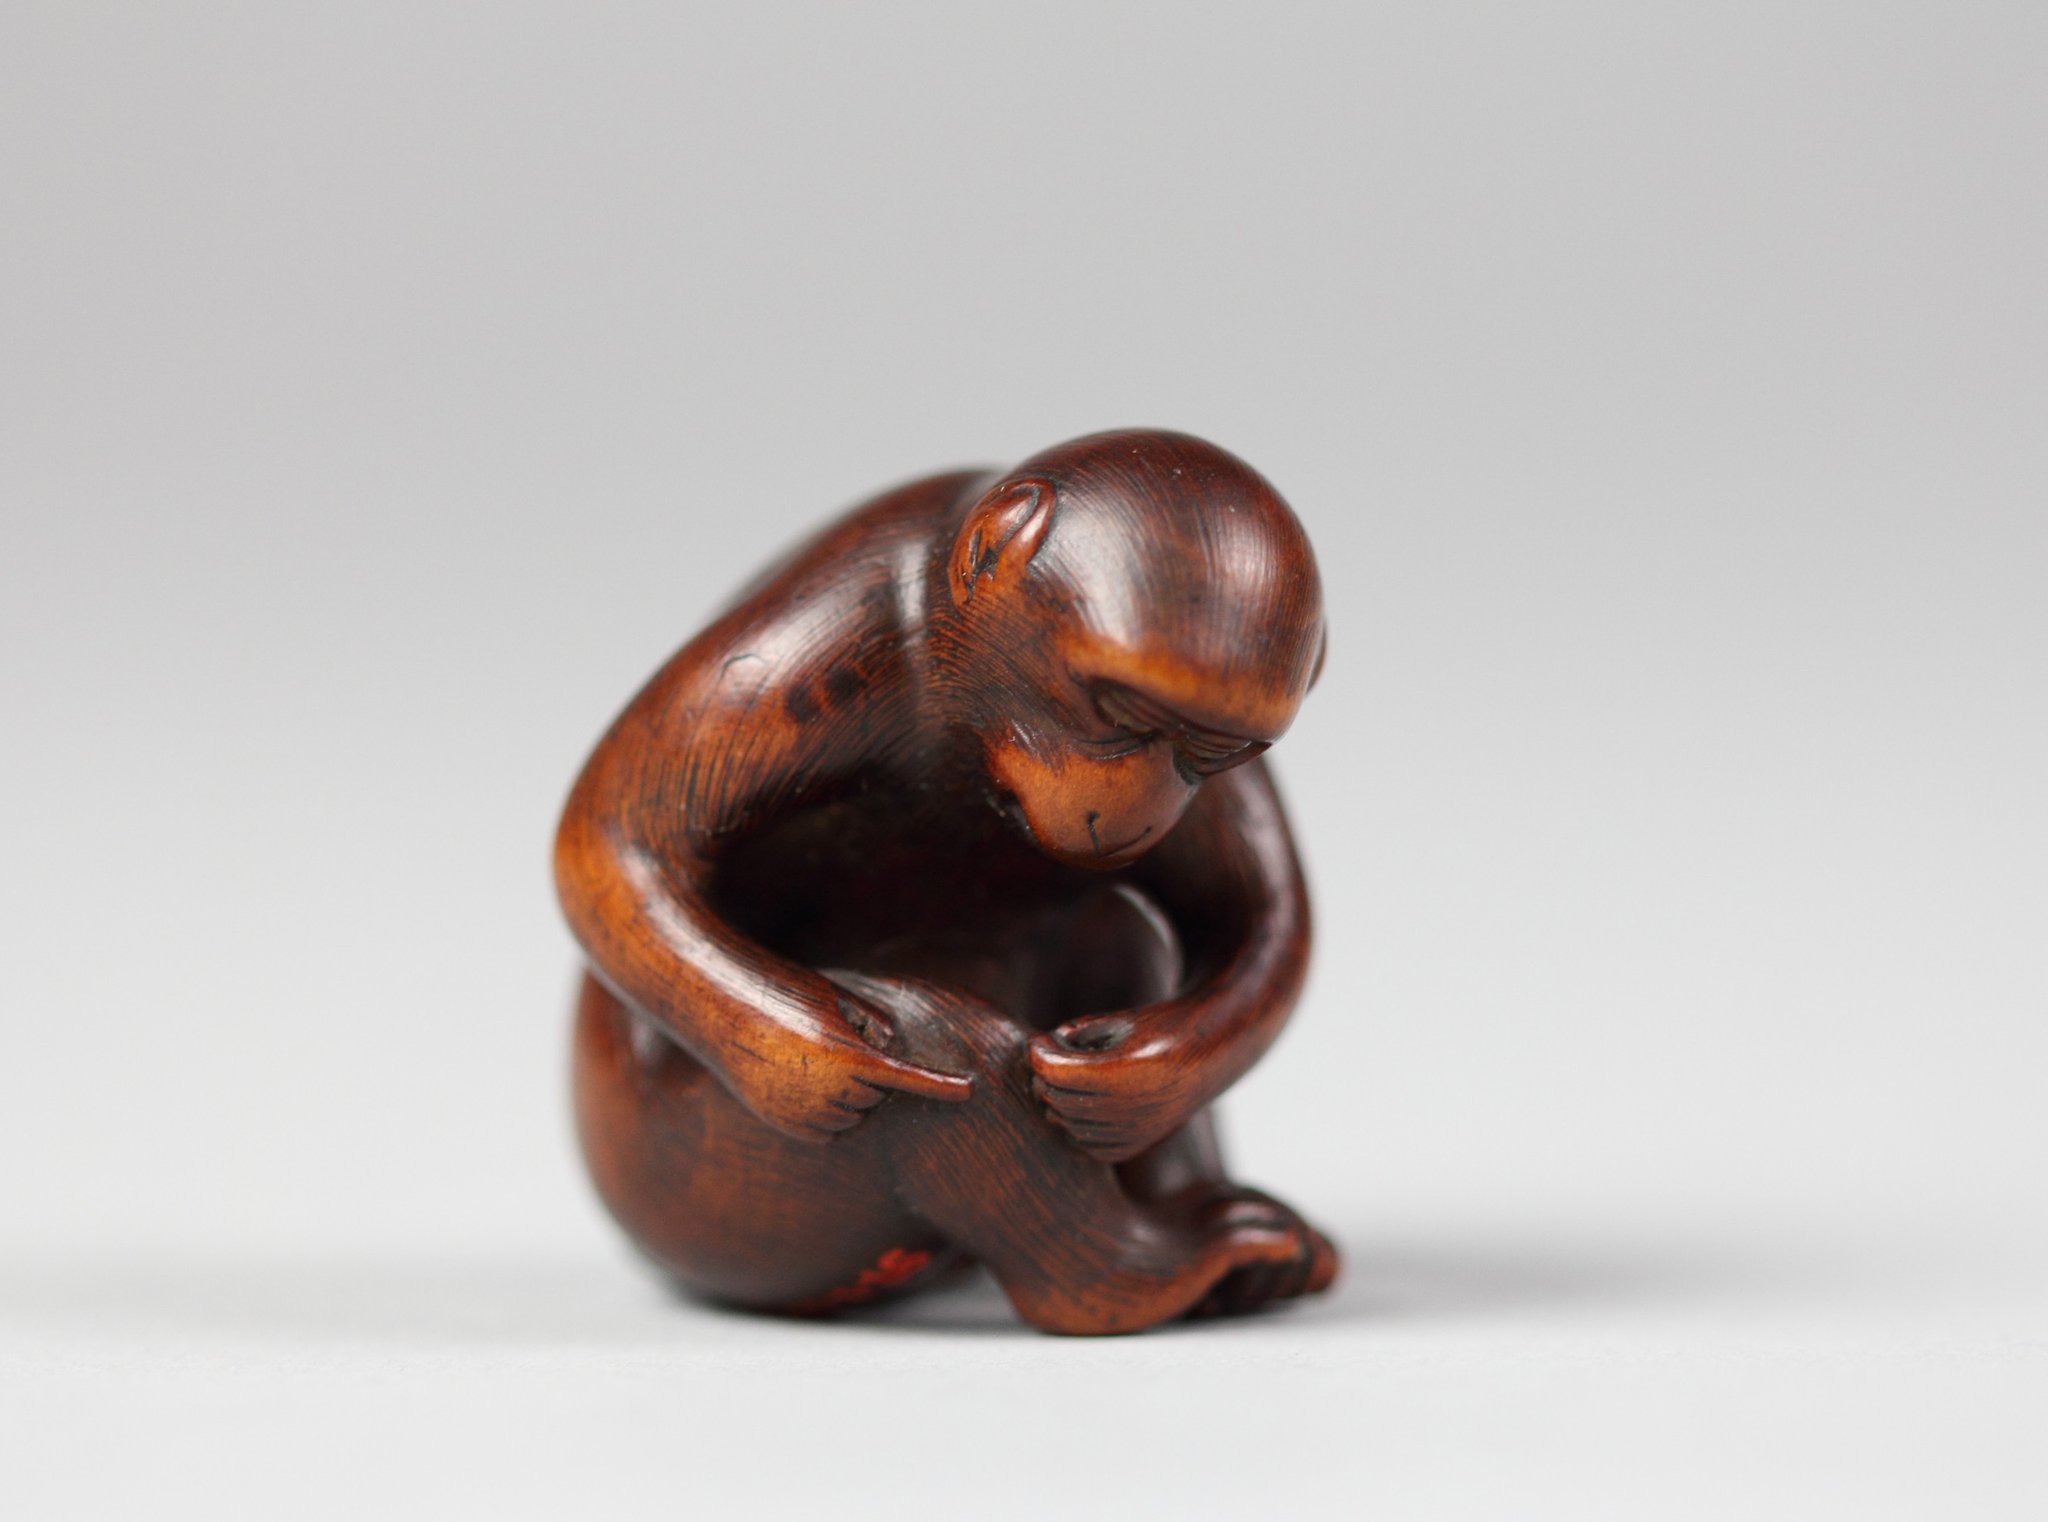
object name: netsuke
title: Netsuke of Monkey Catching Fleas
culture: japanese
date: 1701-1900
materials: wood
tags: monkeys